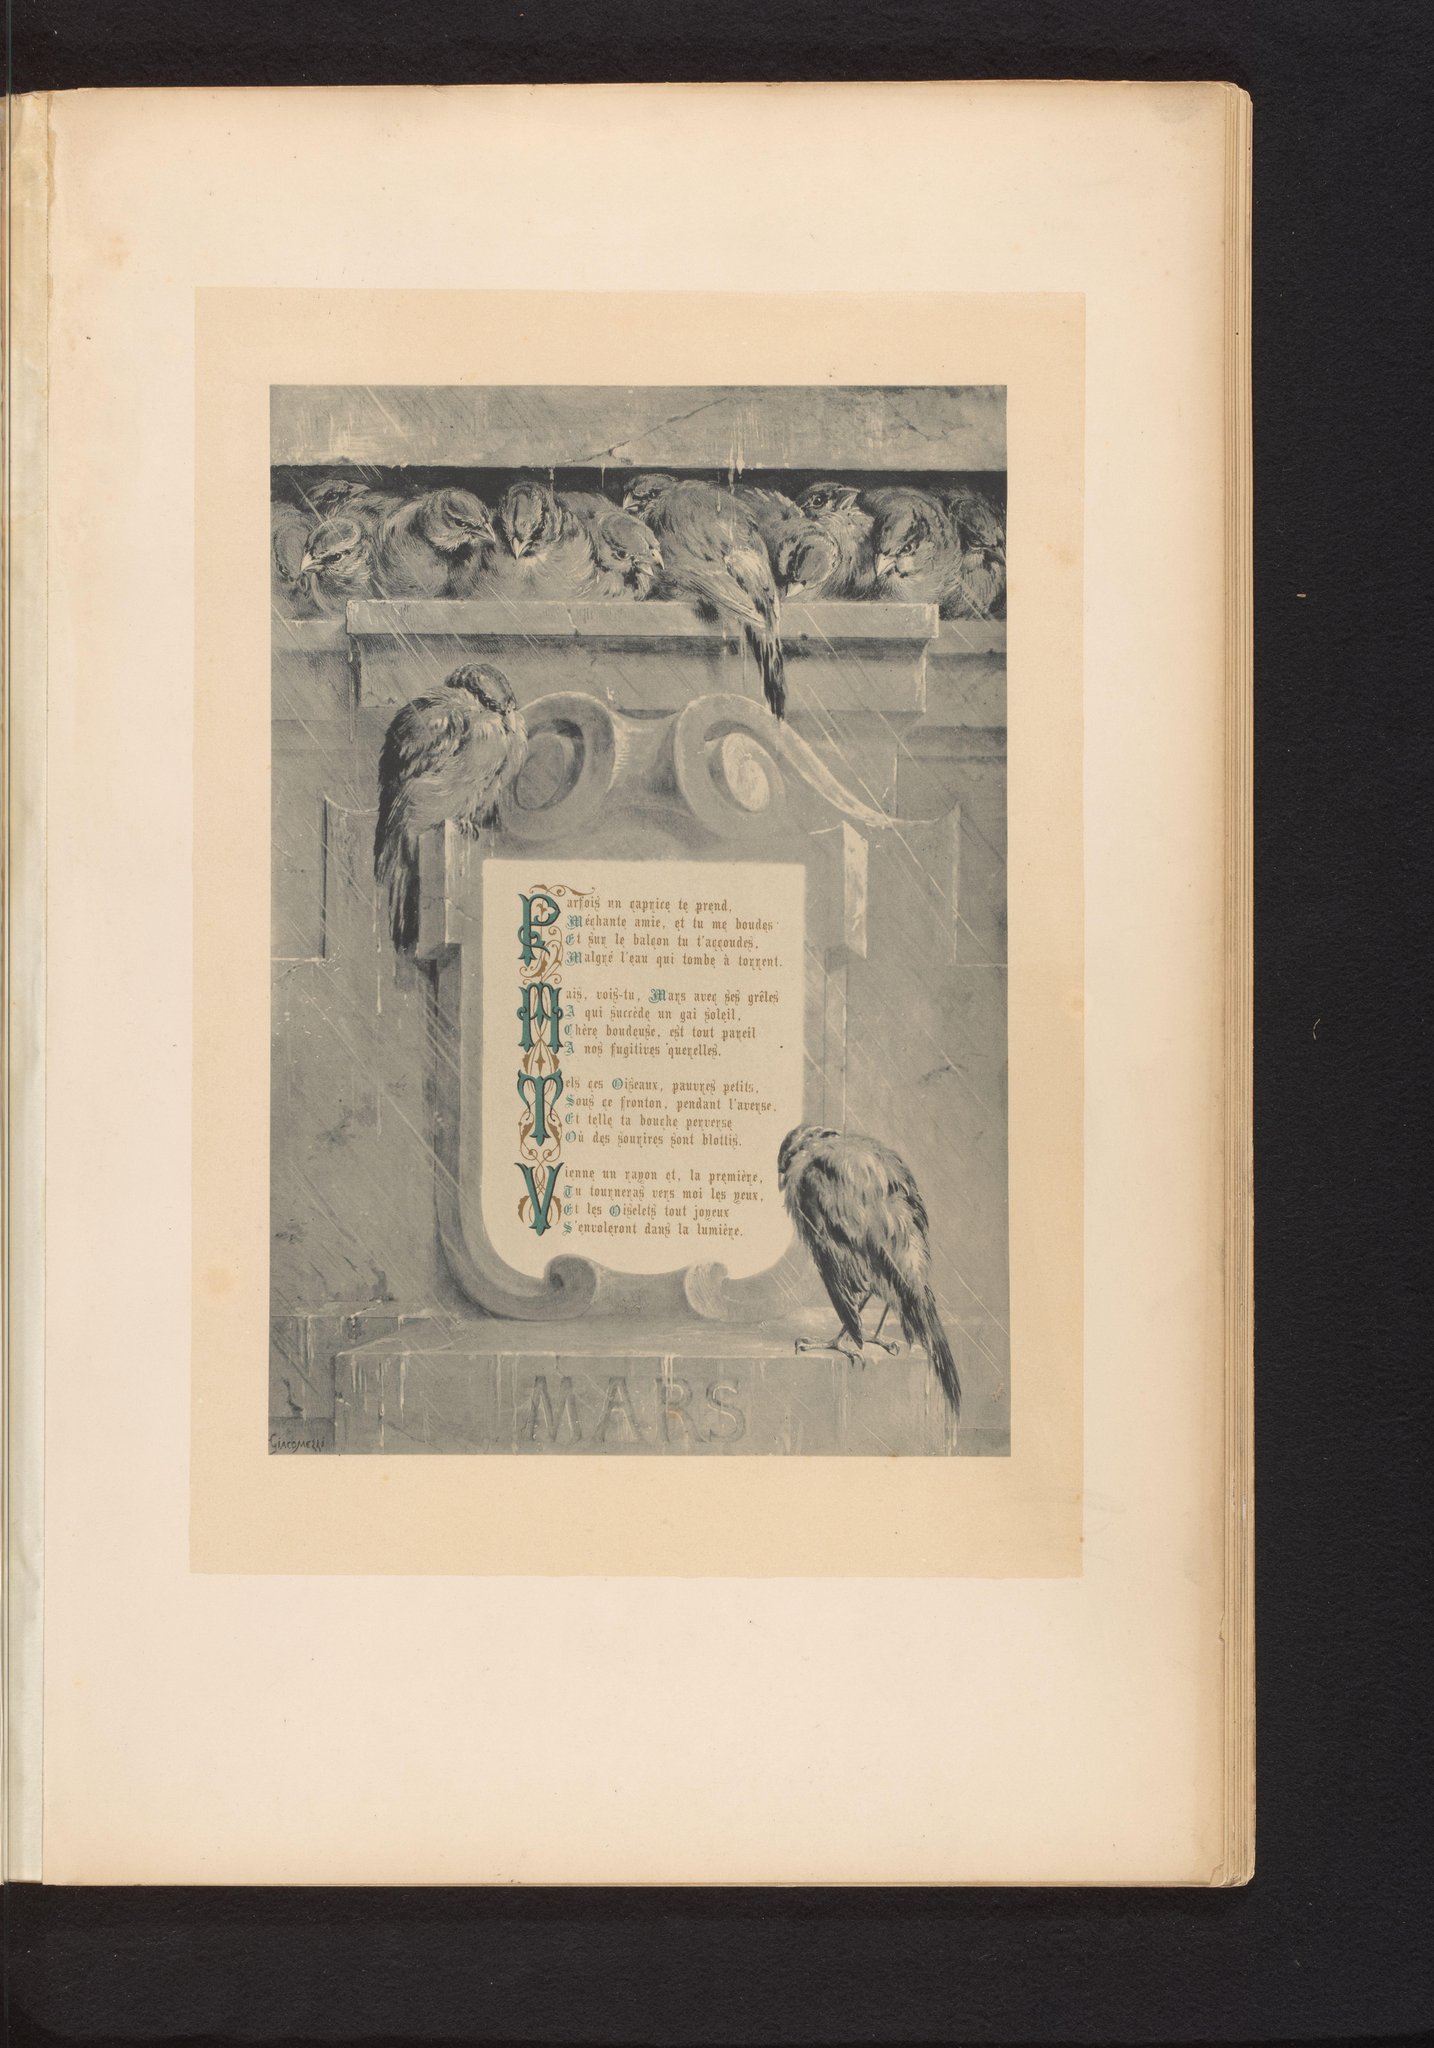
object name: reproduction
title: Reproductie van een prent van vogels op een gebeeldhouwde cartouche, met het gedicht Mars van François Coppée, door Hector Giacomelli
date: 1871-1876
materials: paper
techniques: chromolithography, photograph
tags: birds, ornament ~ cartouche (+ stone ~ ornaments), march ~ other concepts